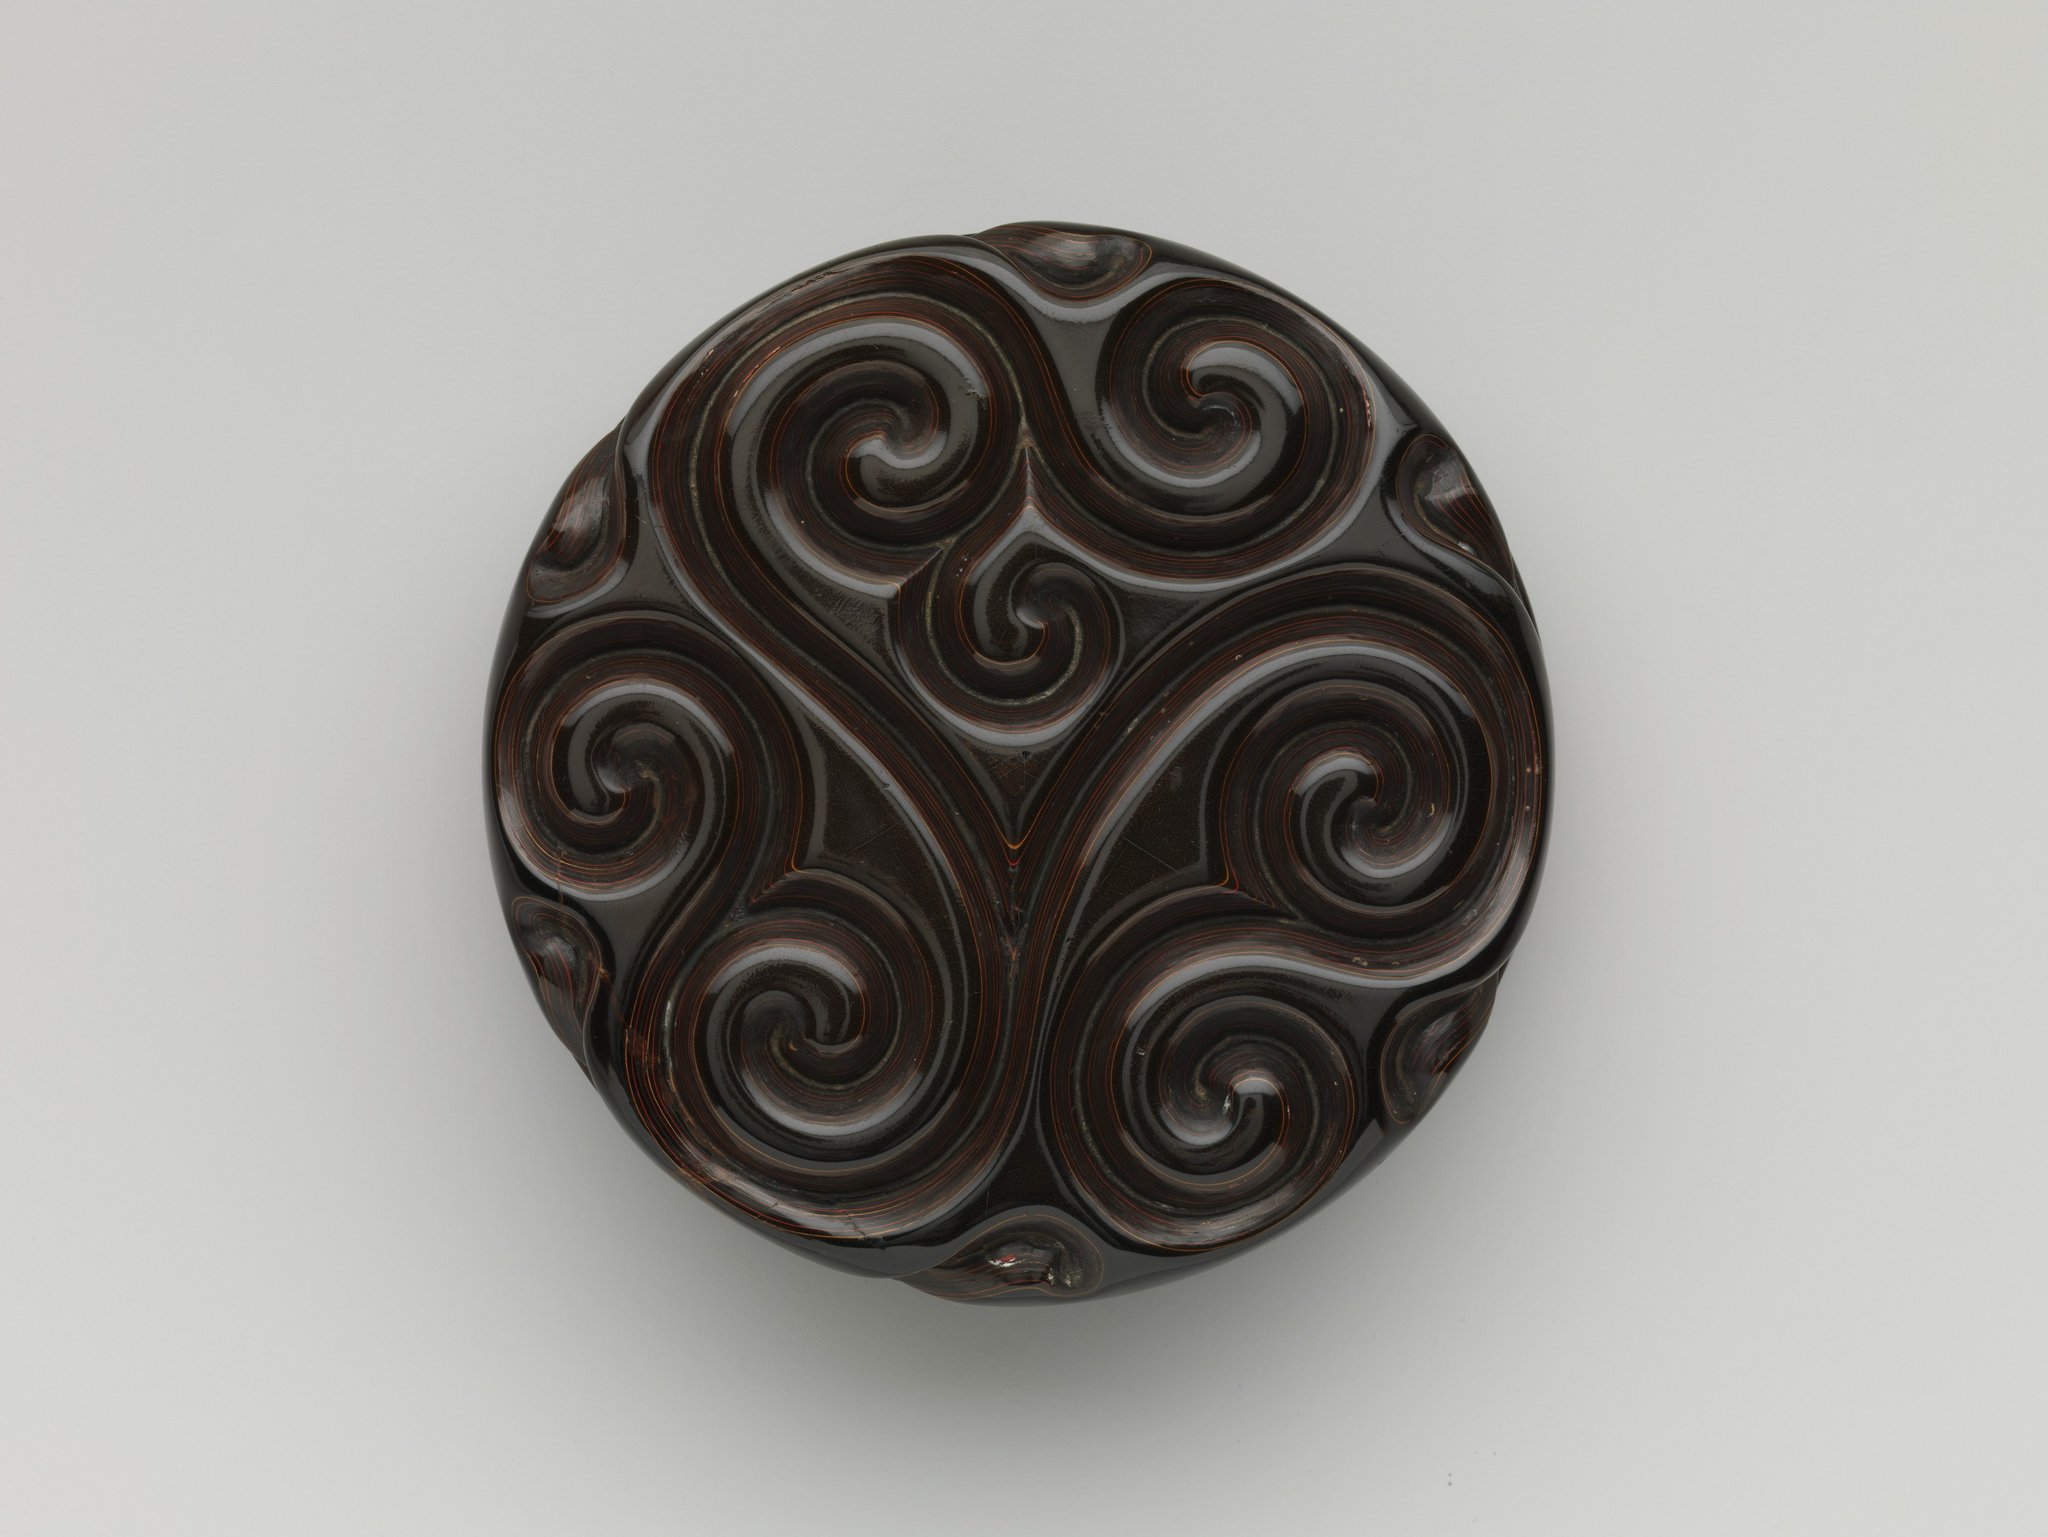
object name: box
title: Incense box with fragrant grass design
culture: chinese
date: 1201-1300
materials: lacquer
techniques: carving